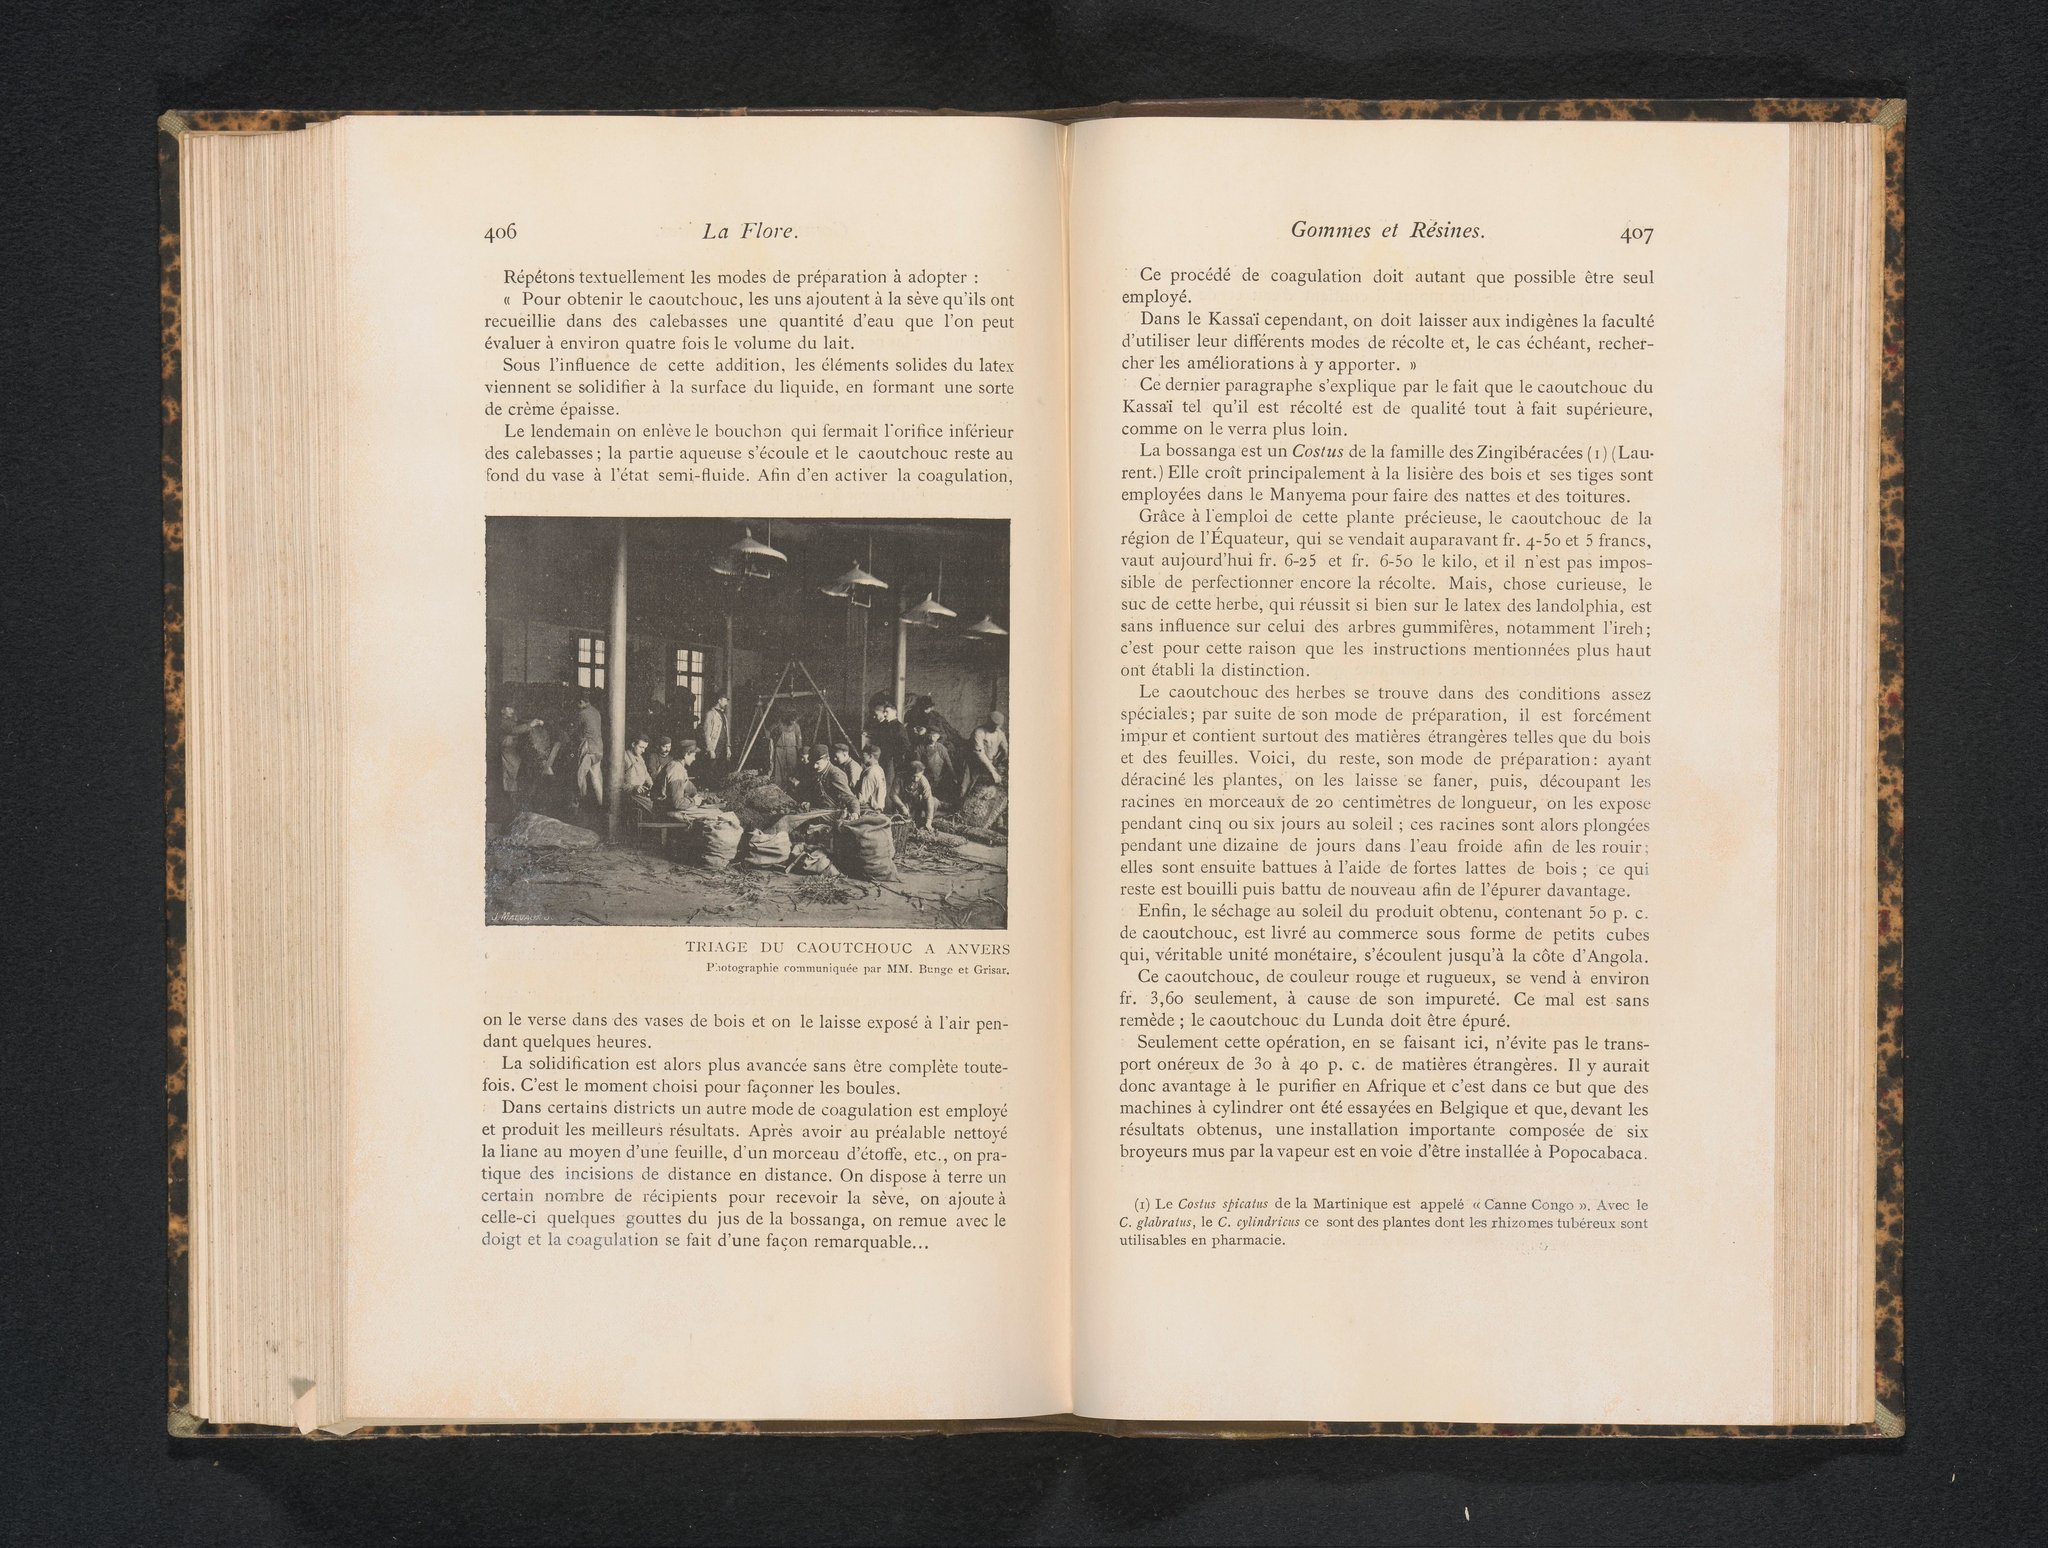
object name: photomechanical print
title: Triage du caoutchouc a Anvers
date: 1887-1892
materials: paper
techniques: autotype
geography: antwerp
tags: large-scale structure for storage, e.g.: warehouse, depot, silo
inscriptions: inscription: ‘Photographie communiquée par MM. Bunge et Grisar.’